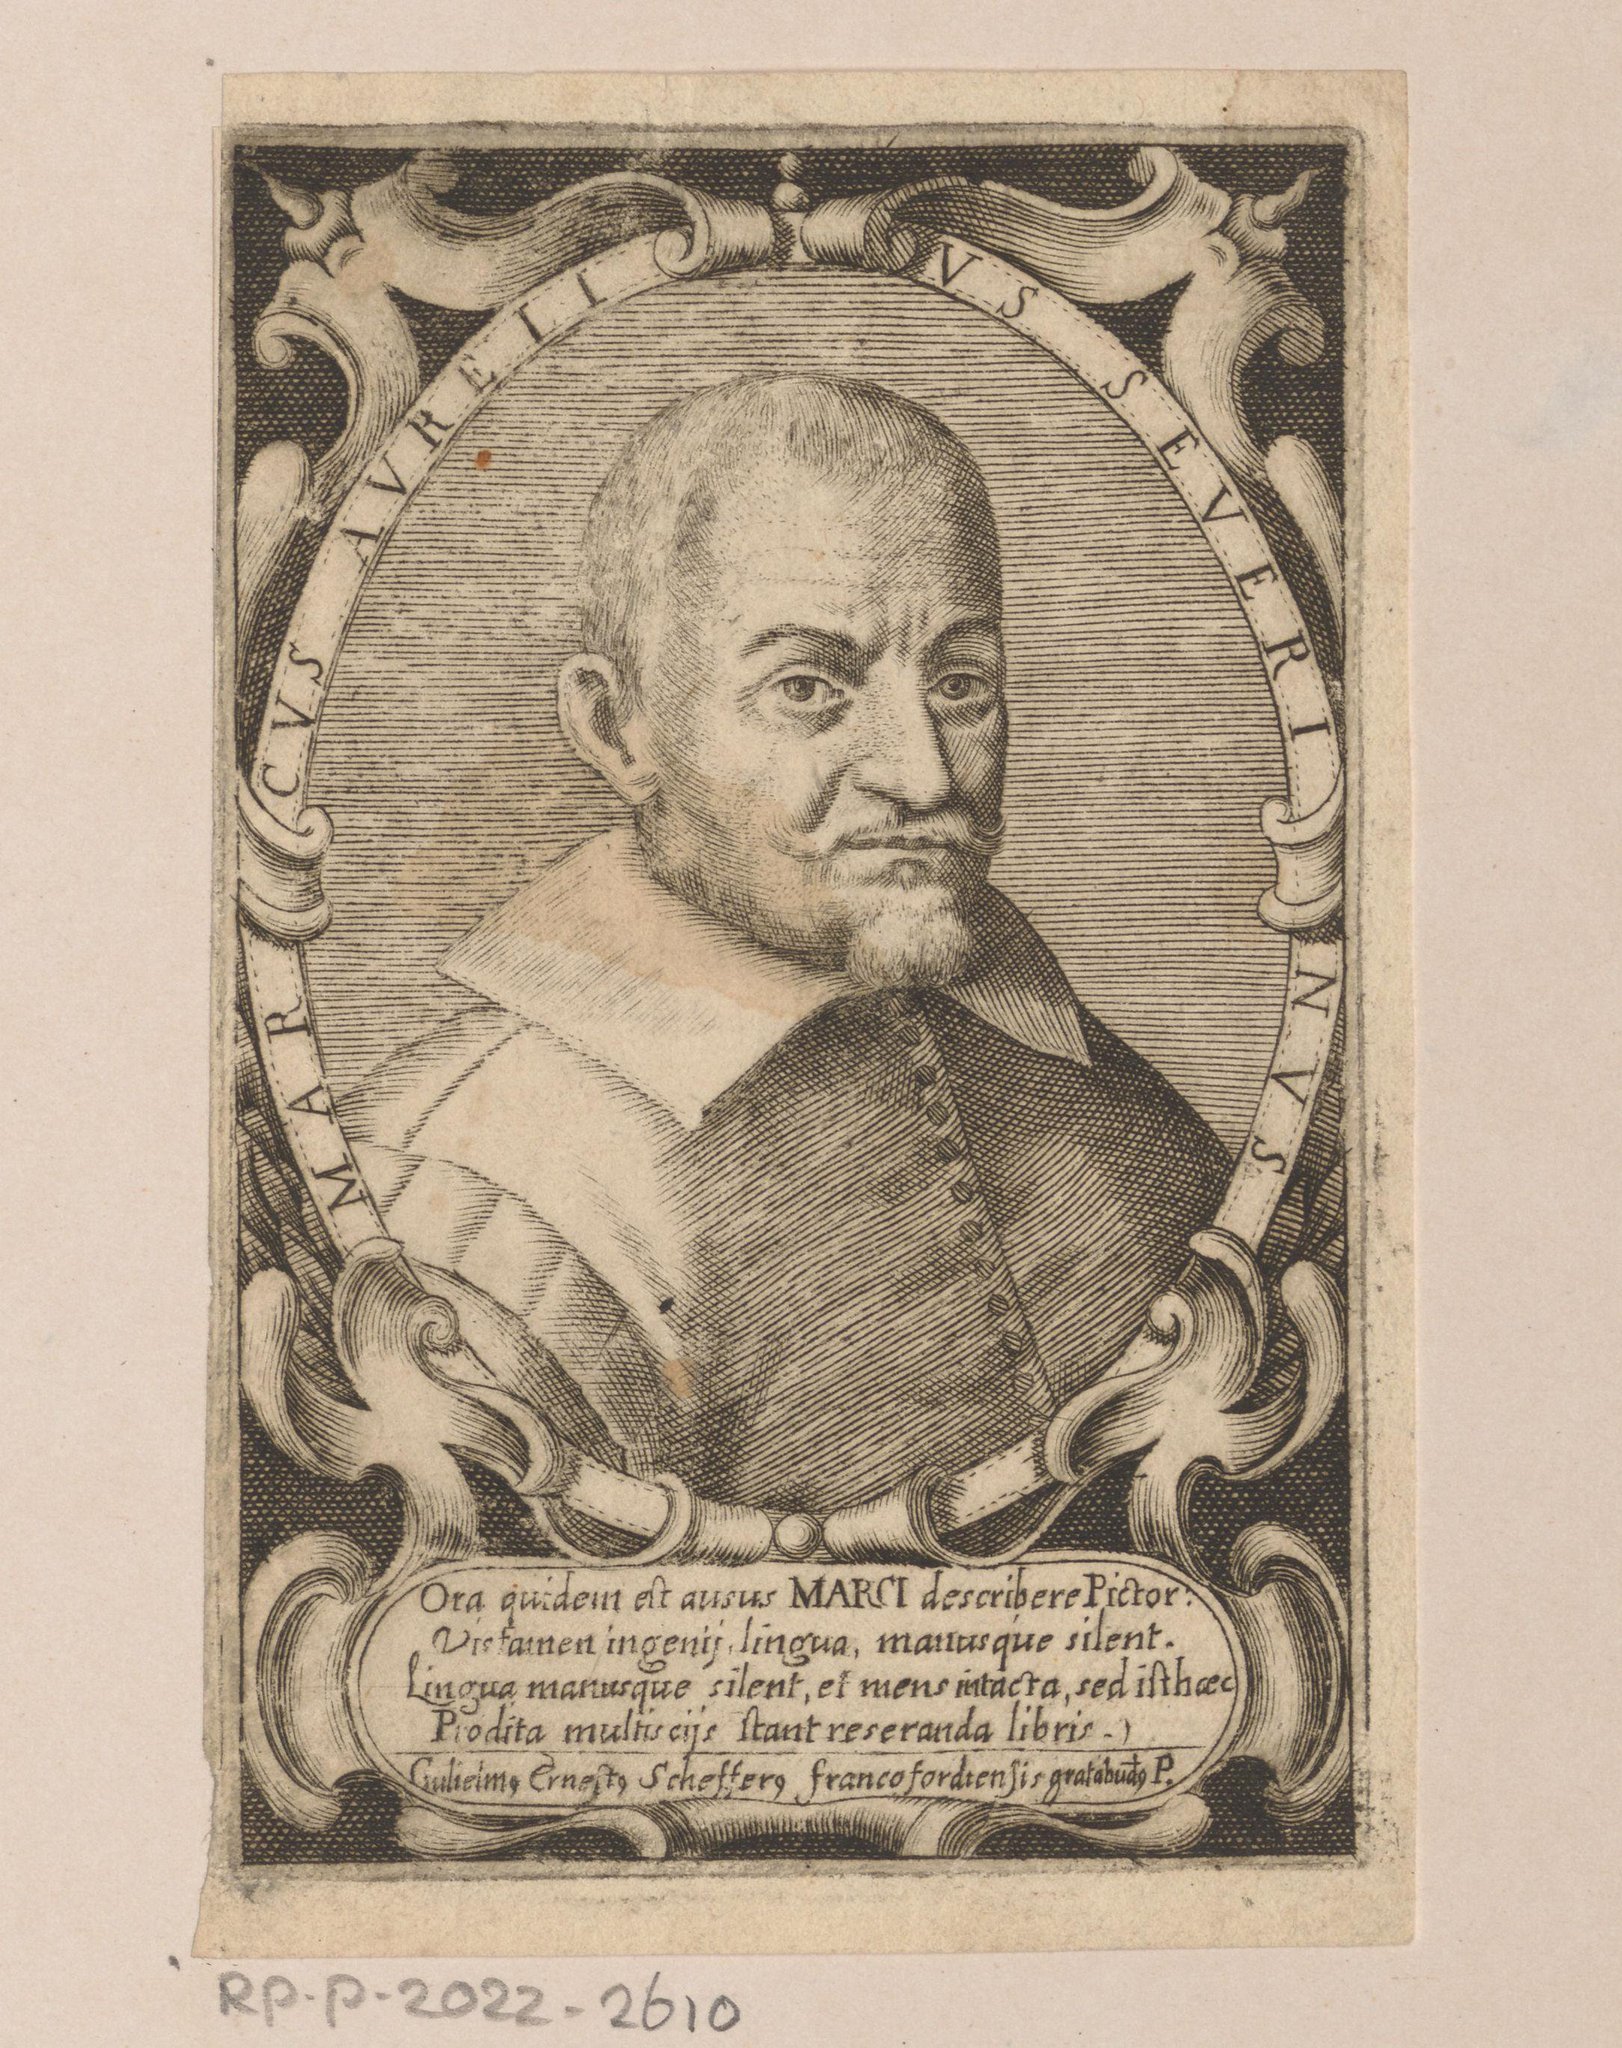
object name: print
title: Portret van Marco Aurelio Severino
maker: Anonymous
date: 1653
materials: paper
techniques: engraving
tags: naples, historical persons, physiology and anatomy (+ portrait of scholar, scientist), barber; surgeon, physician, doctor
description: Prent waarschijnlijk uit: Severino, Marco Aurelio. Therapeuta Neapolitanus. Napels: Roberti Molli, 1653.